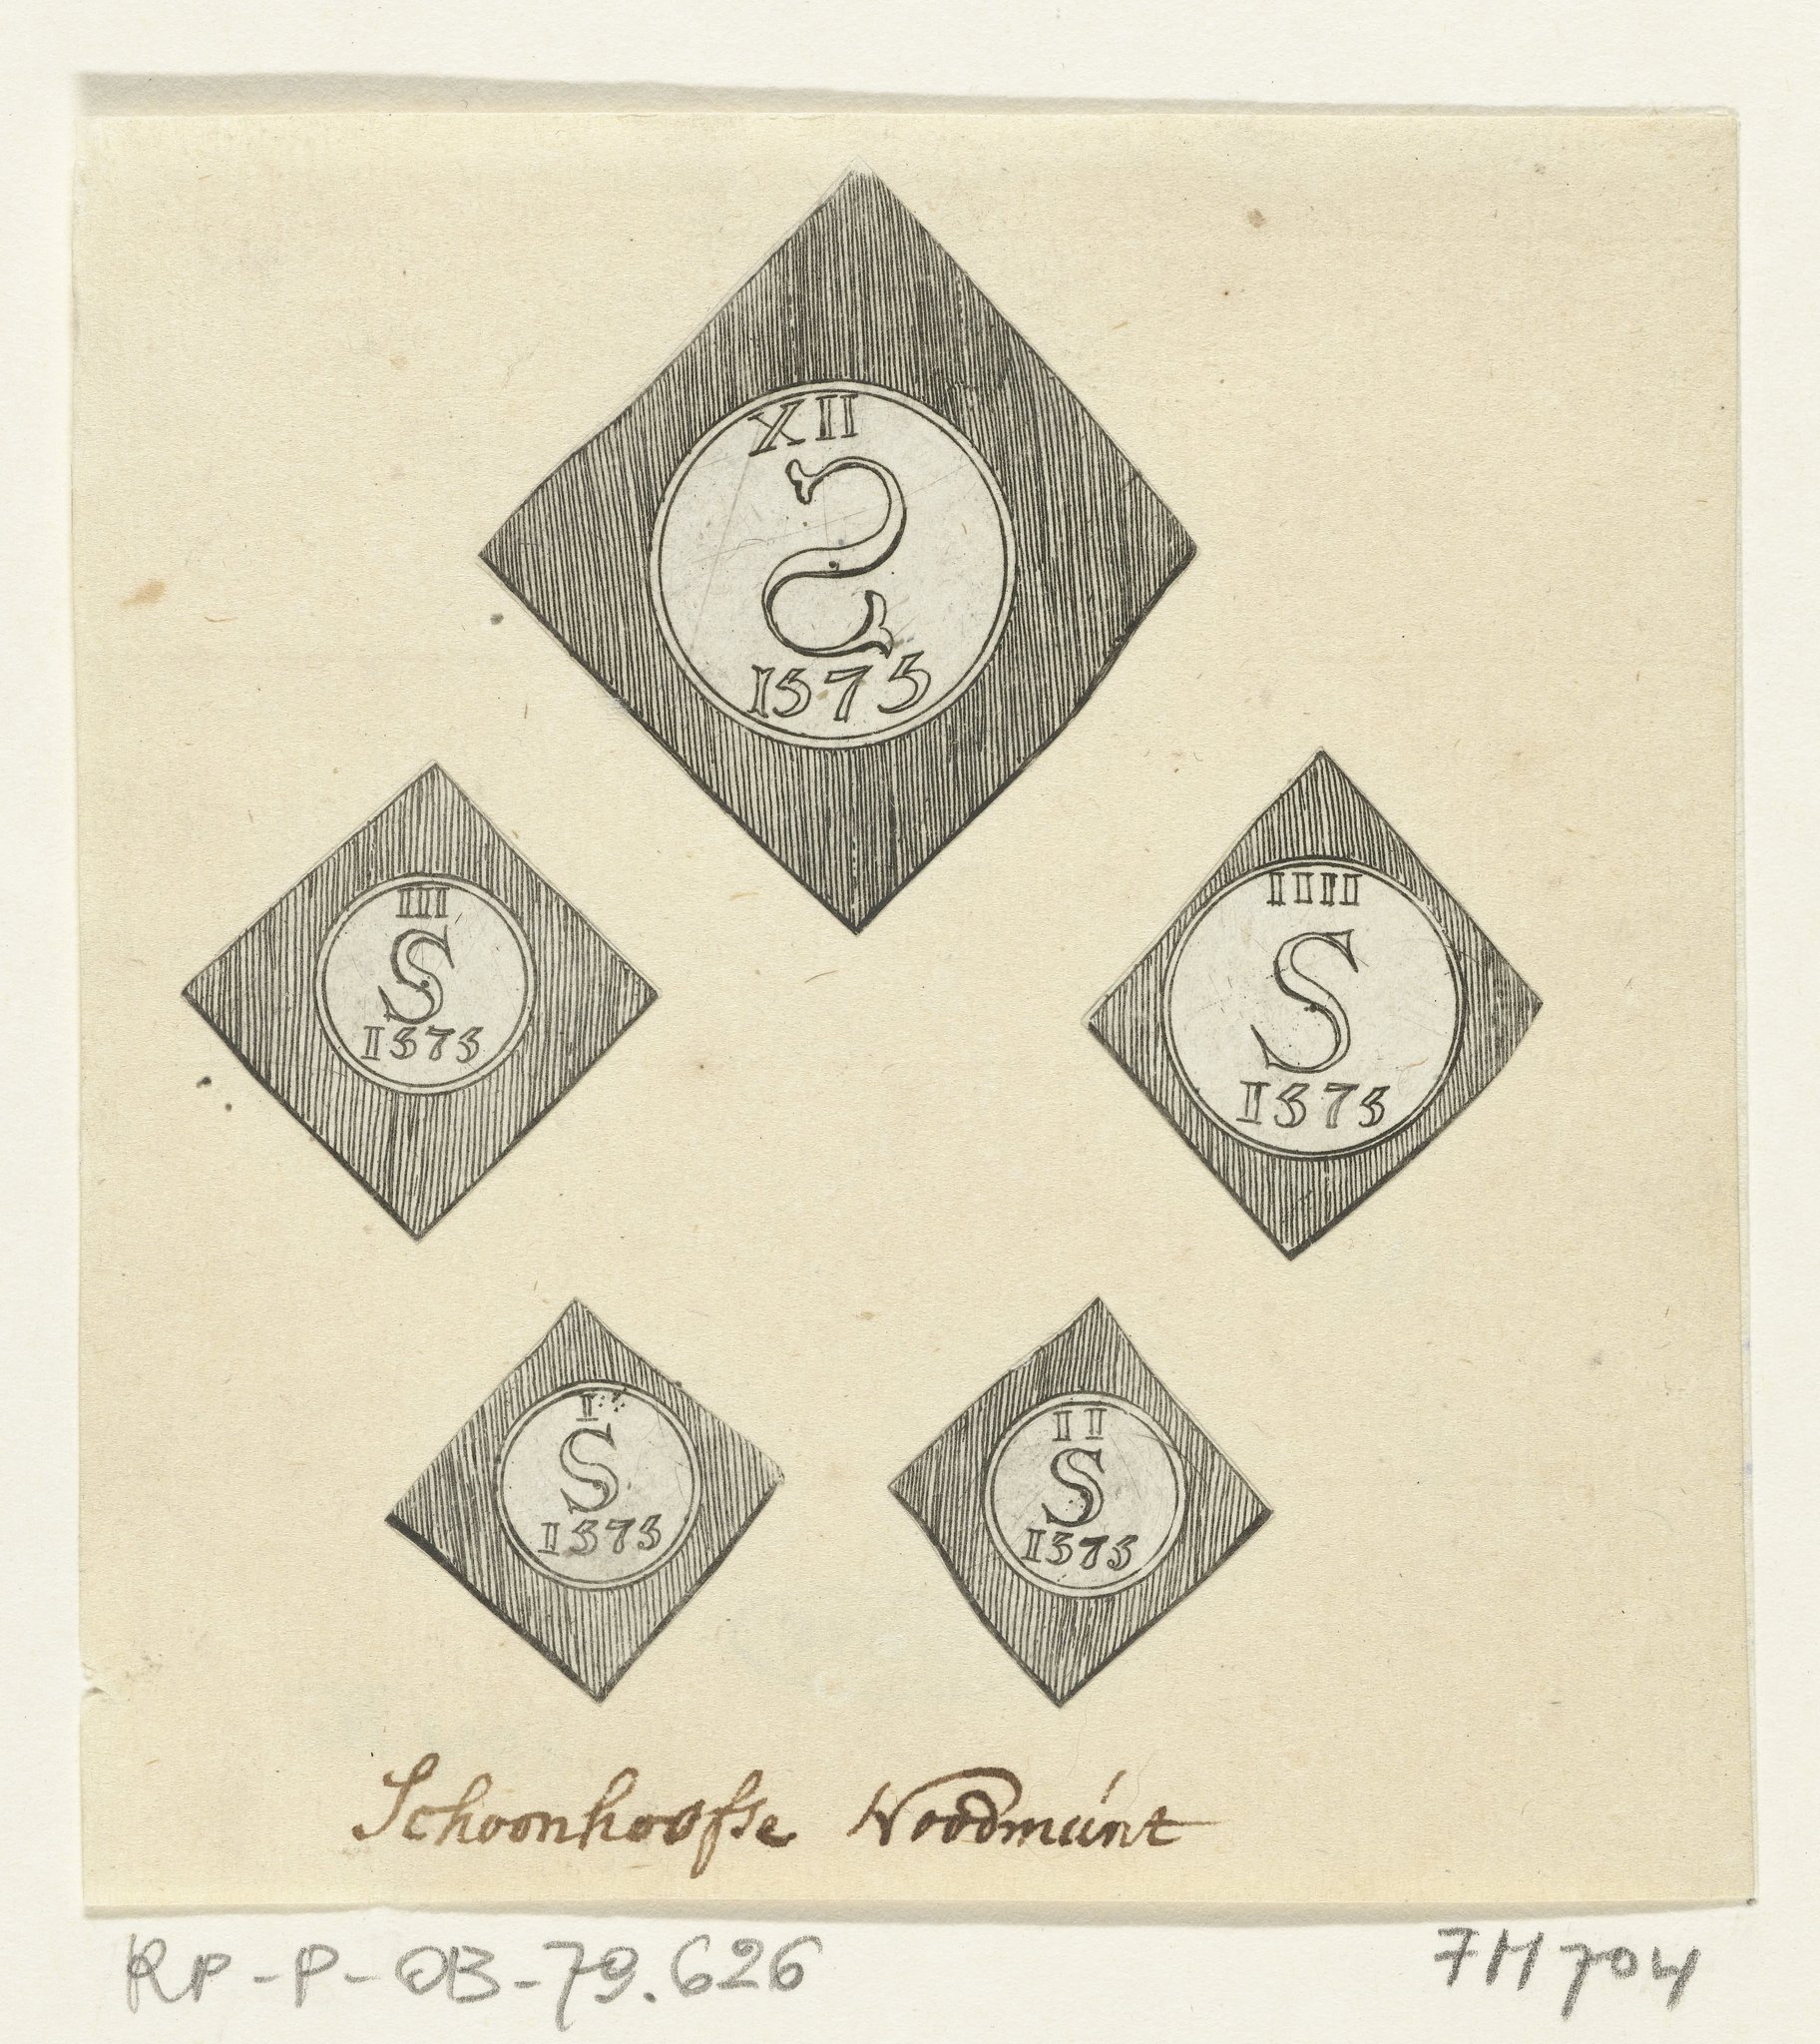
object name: historical object representation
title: Vijf noodmunten geslagen tijdens het beleg van Schoonhoven, 1575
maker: Anonymous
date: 1600-1799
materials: paper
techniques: etching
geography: netherlands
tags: schoonhoven, beleg van schoonhoven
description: Vijf noodmunten geslagen tijdens het beleg van Schoonhoven, 1575. Op de voorzijde: I-IIII en XXII S 1575. Uitgeknipt en opgeplakt, met handgeschreven opschrift.